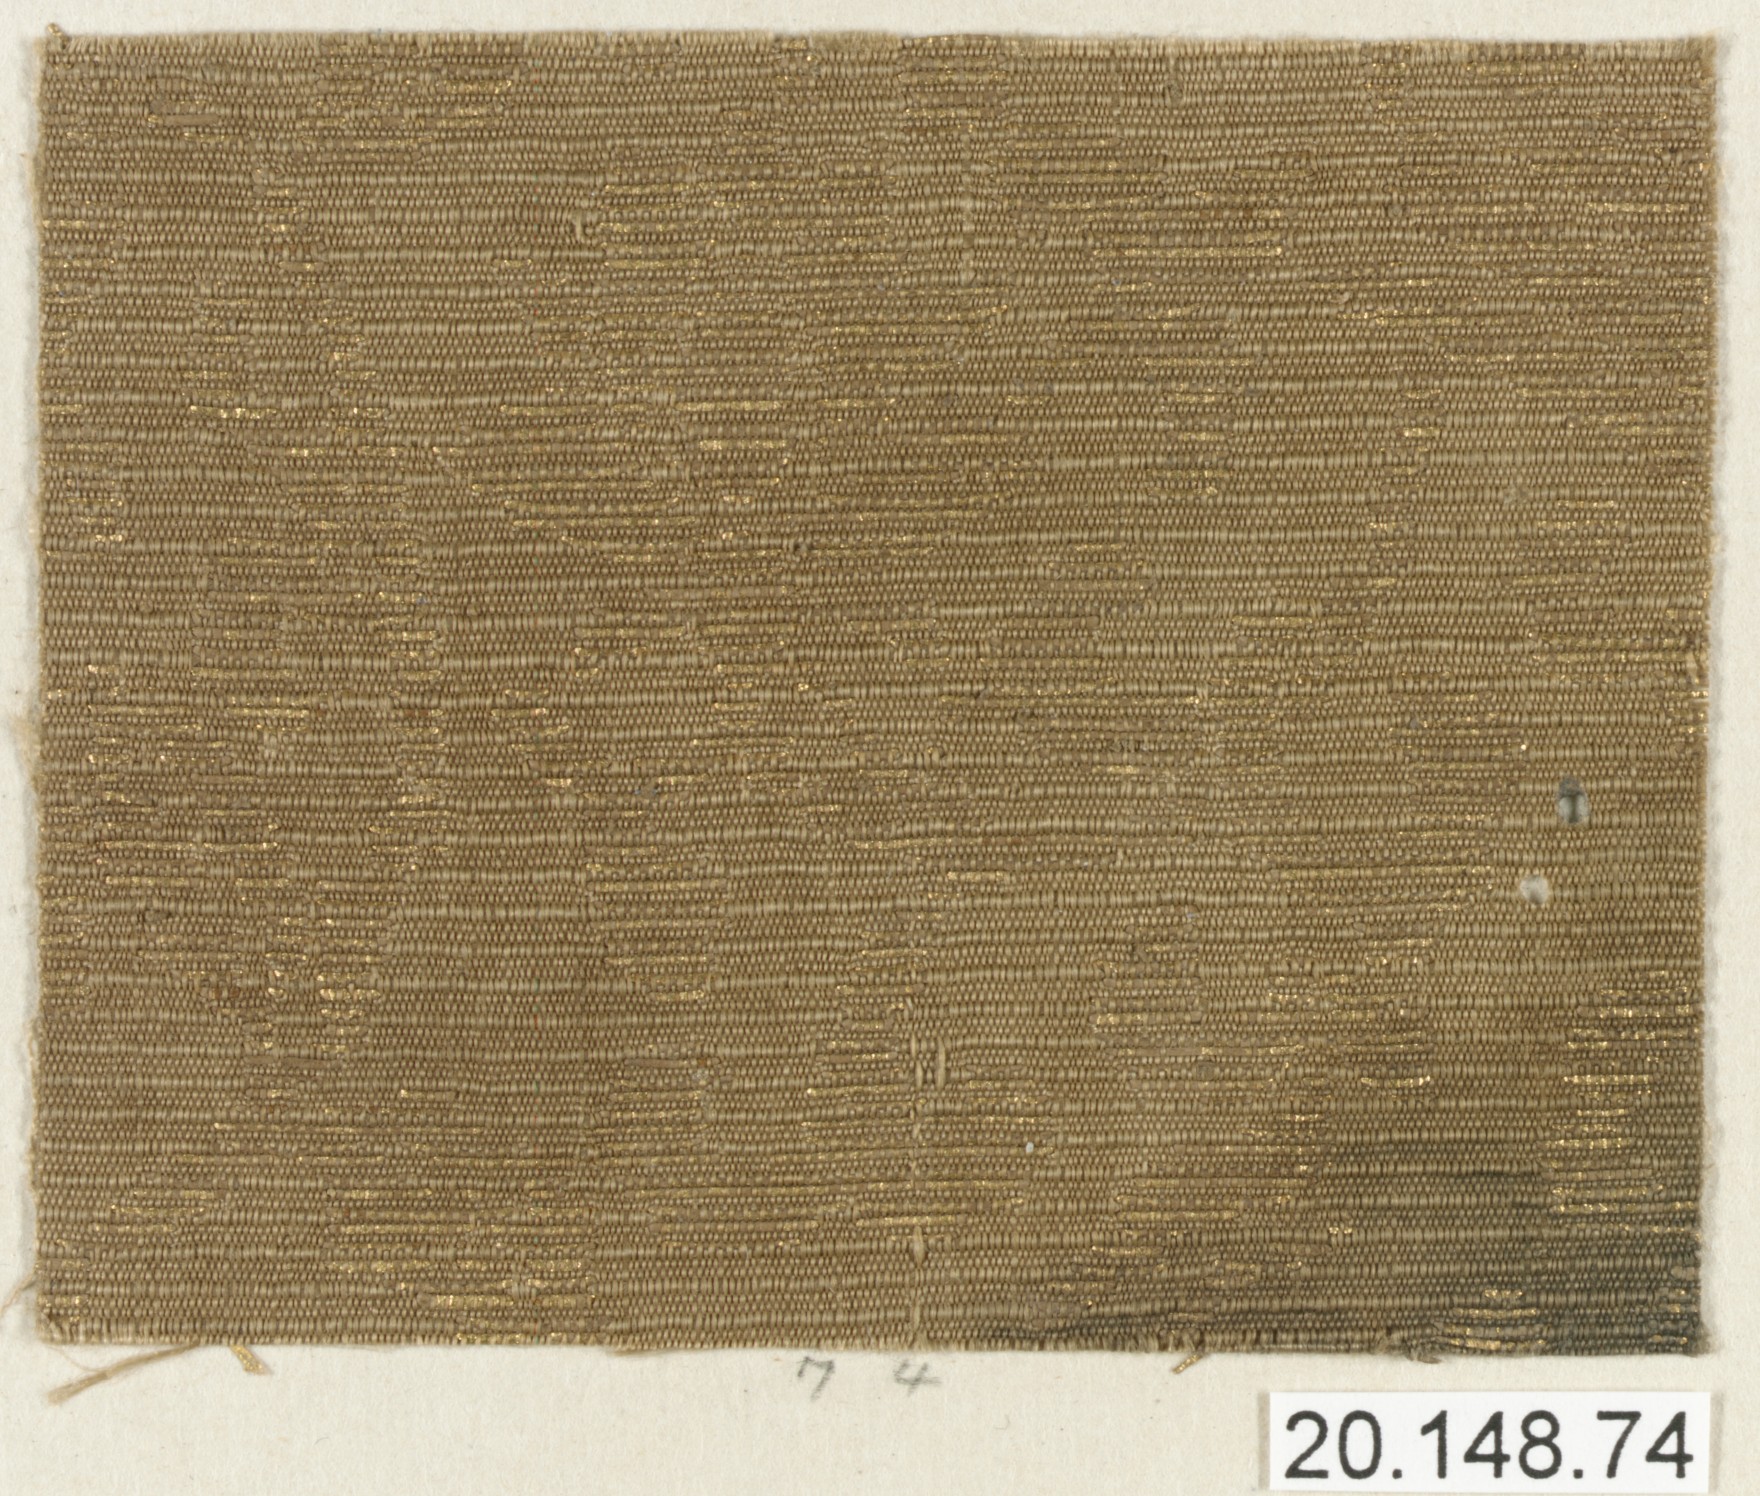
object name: piece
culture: japanese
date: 1601-1700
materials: silk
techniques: compound weave